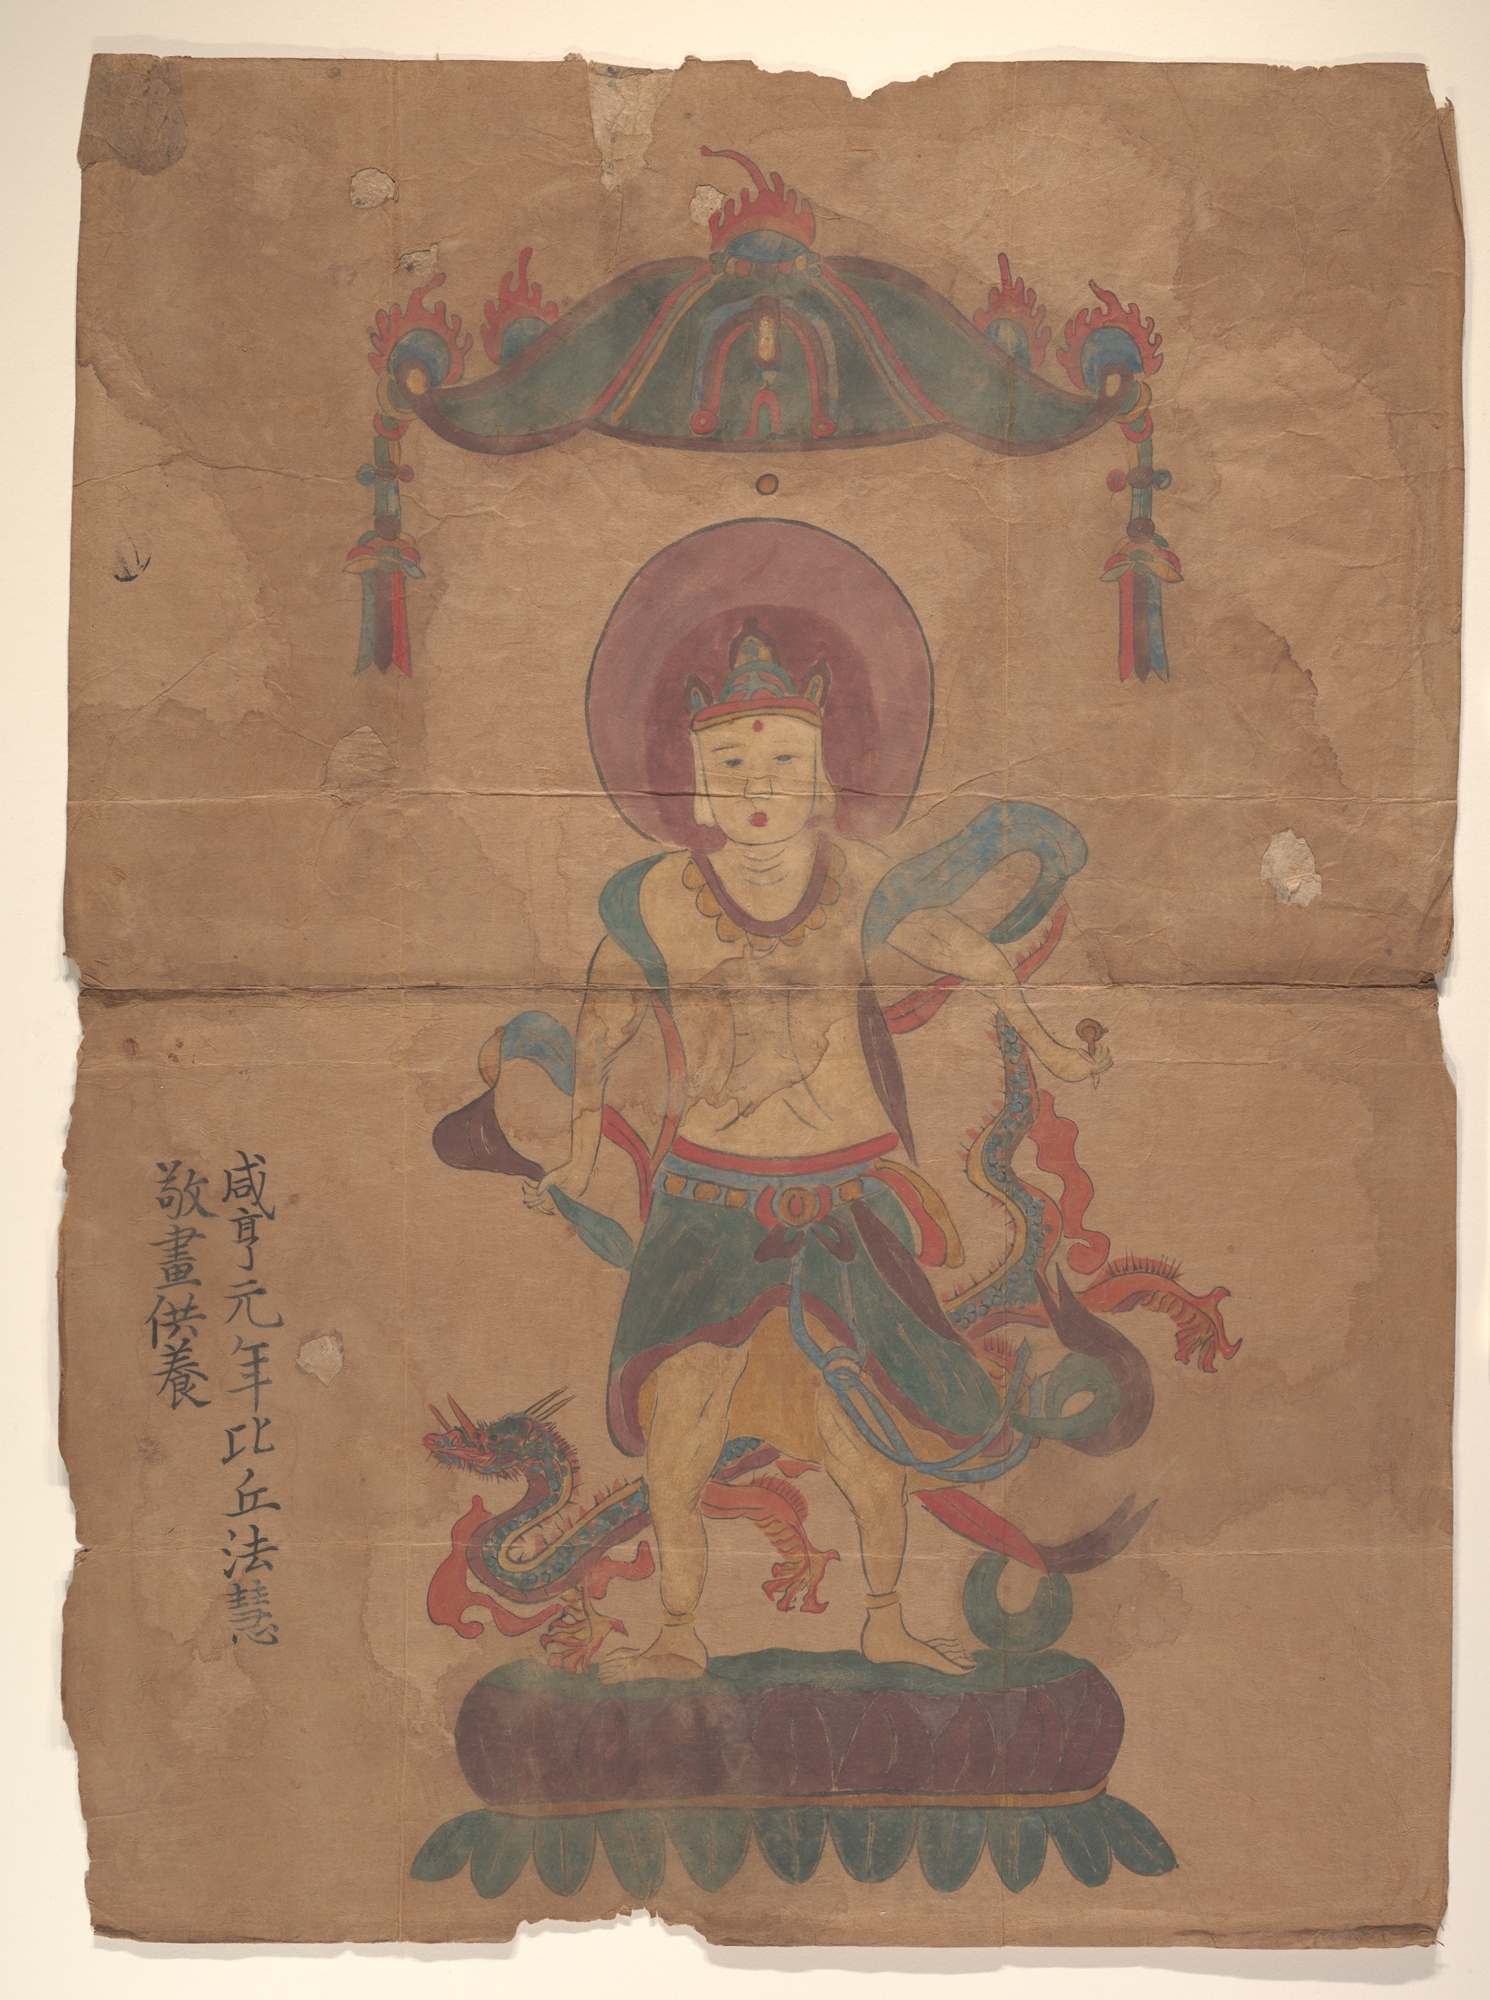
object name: leaf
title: Two Buddhist Paintings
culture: chinese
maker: unidentified artist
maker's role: artist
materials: ink, paper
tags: dragons,buddhism